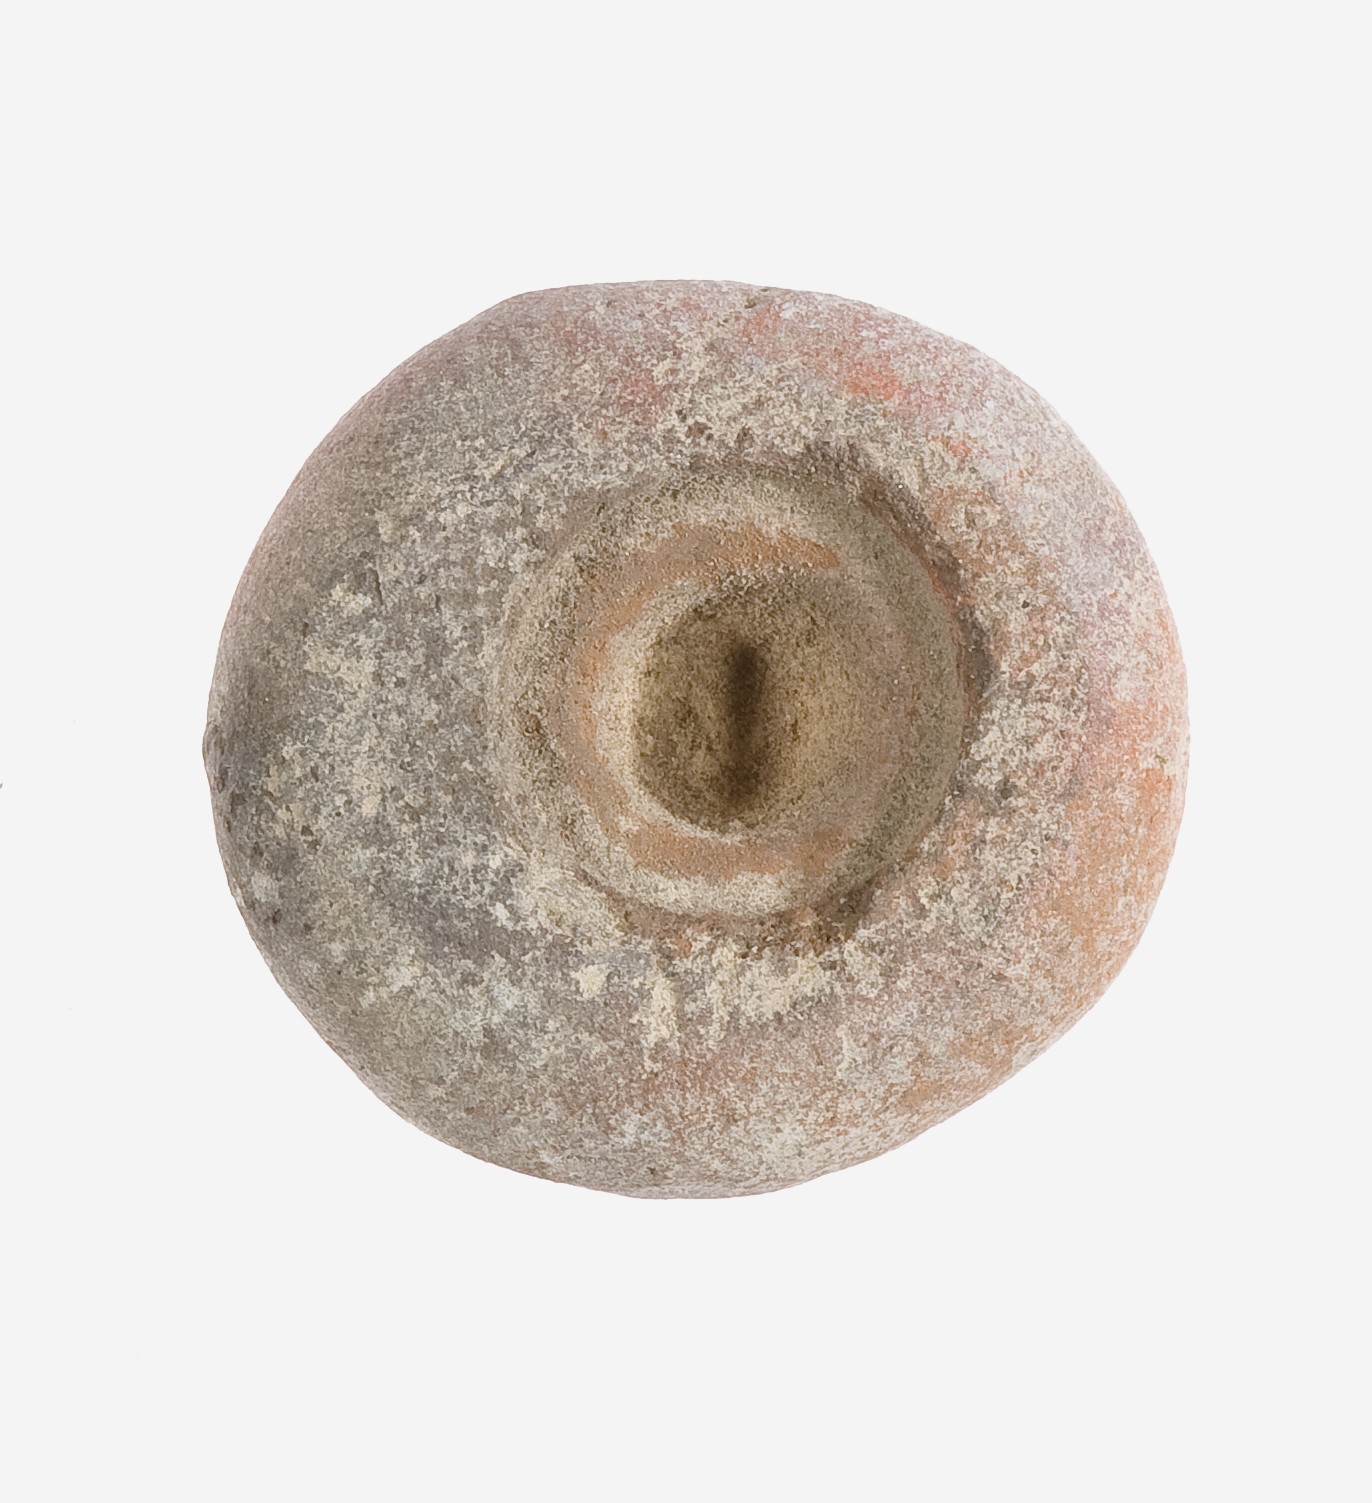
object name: mold, cornflower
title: Ridged Umbel Mold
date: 1390-1352 BCE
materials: pottery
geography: egypt